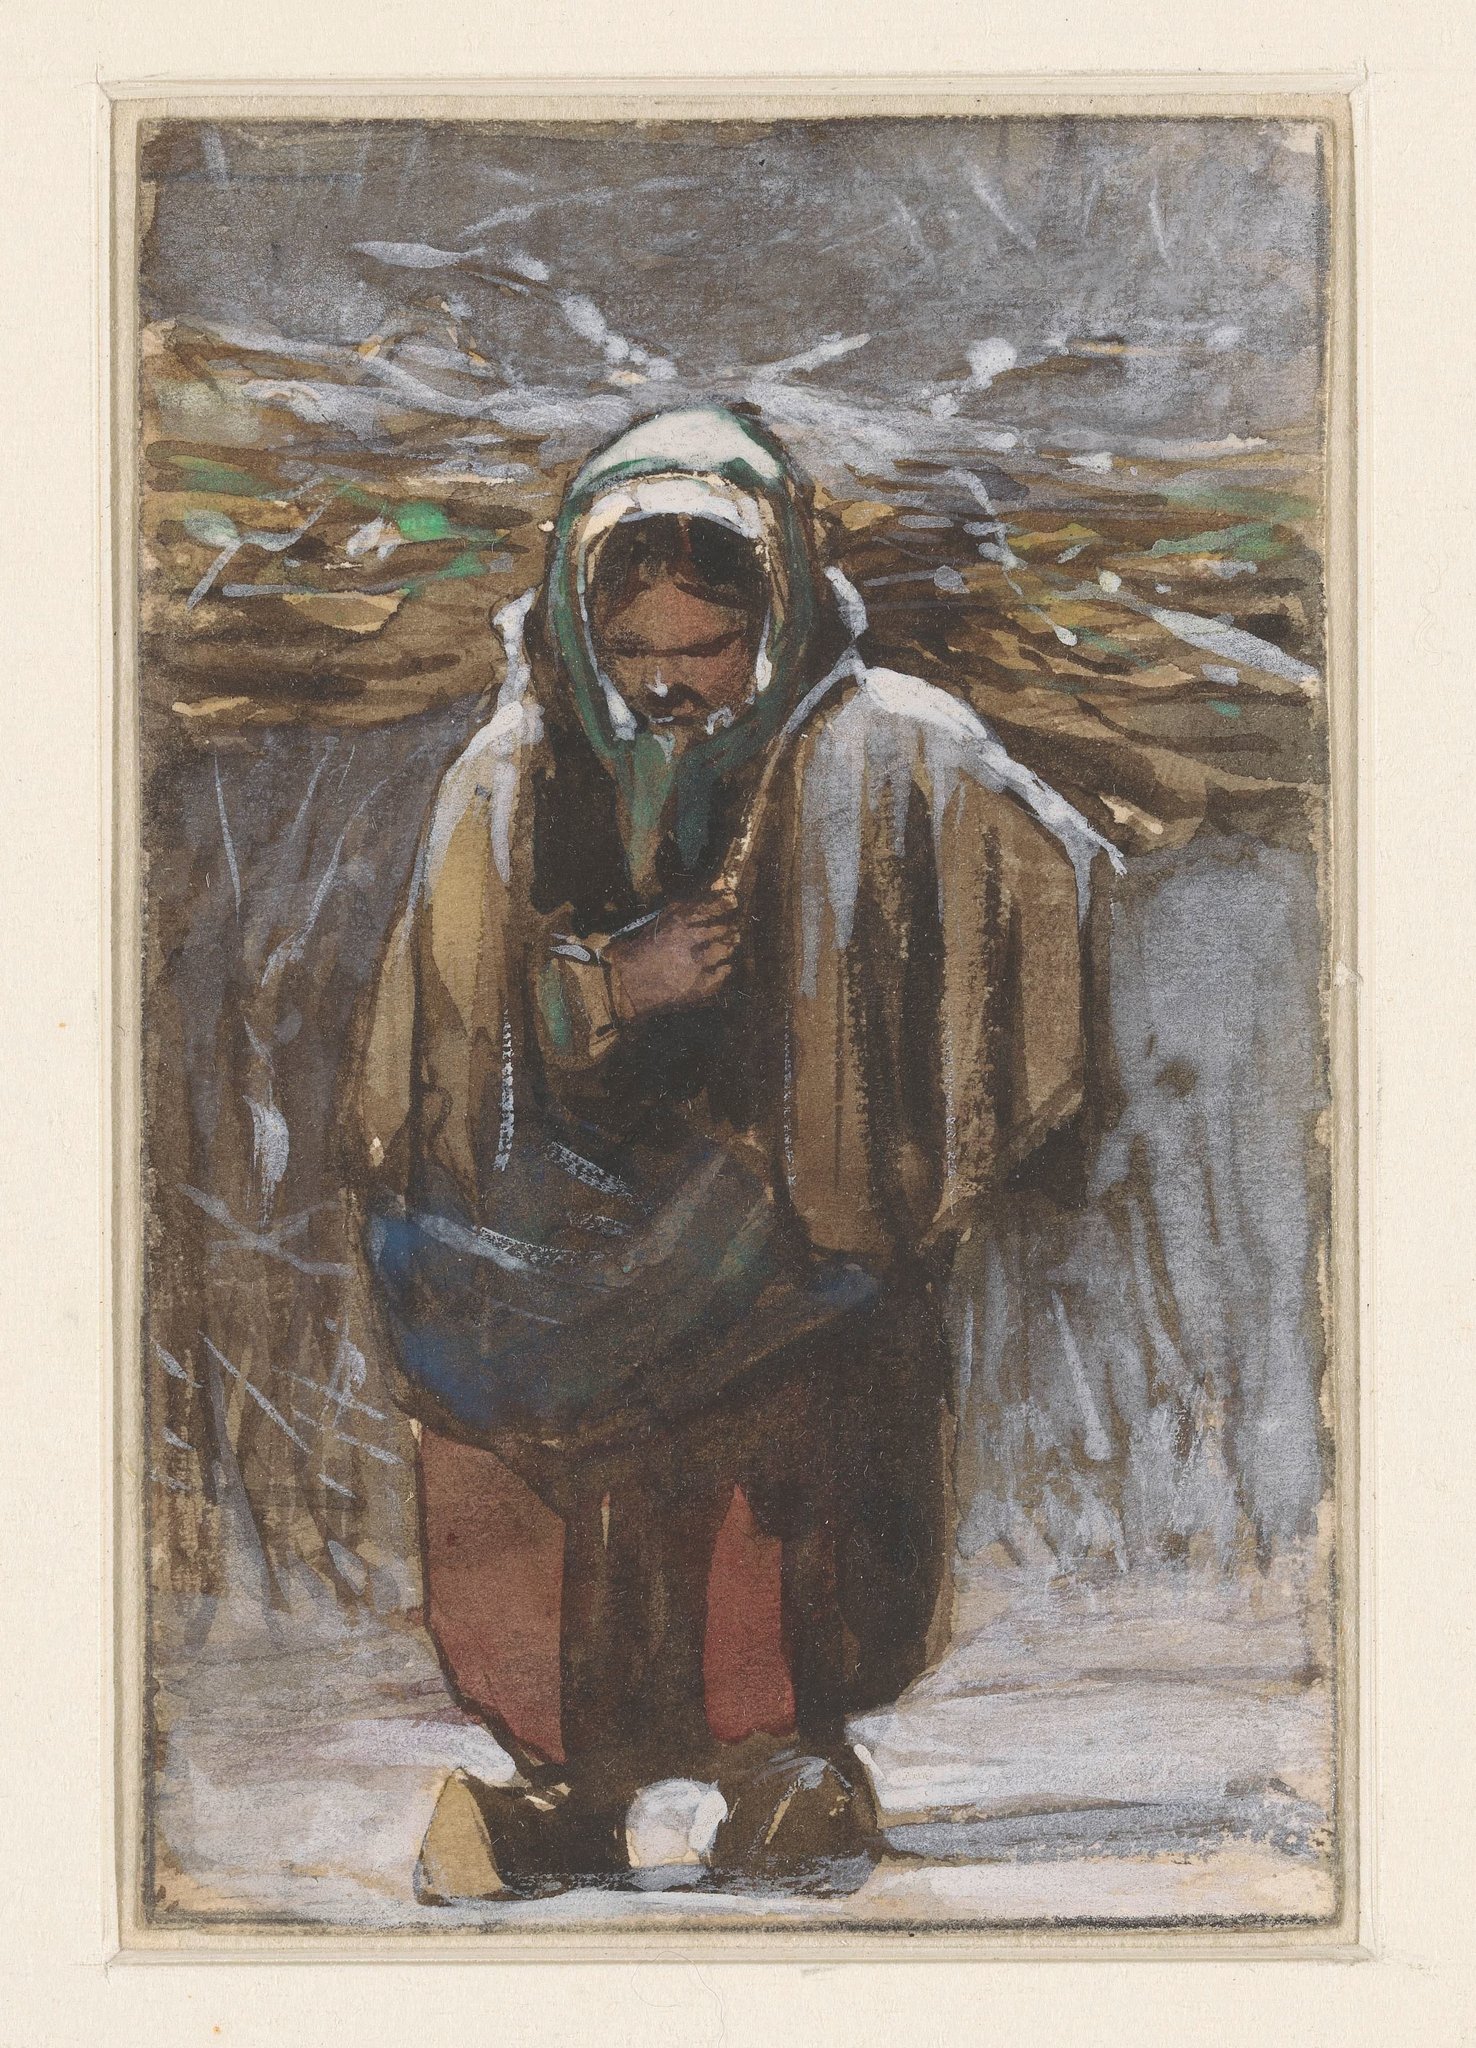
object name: watercolor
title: Boerin met sprokkelhout op haar rug in winterlandschap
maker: jan weissenbruch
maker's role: painter, print maker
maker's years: 1822-1880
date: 1832-1880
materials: paper, watercolor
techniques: brush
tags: woodgathering, woodgatherer, snow